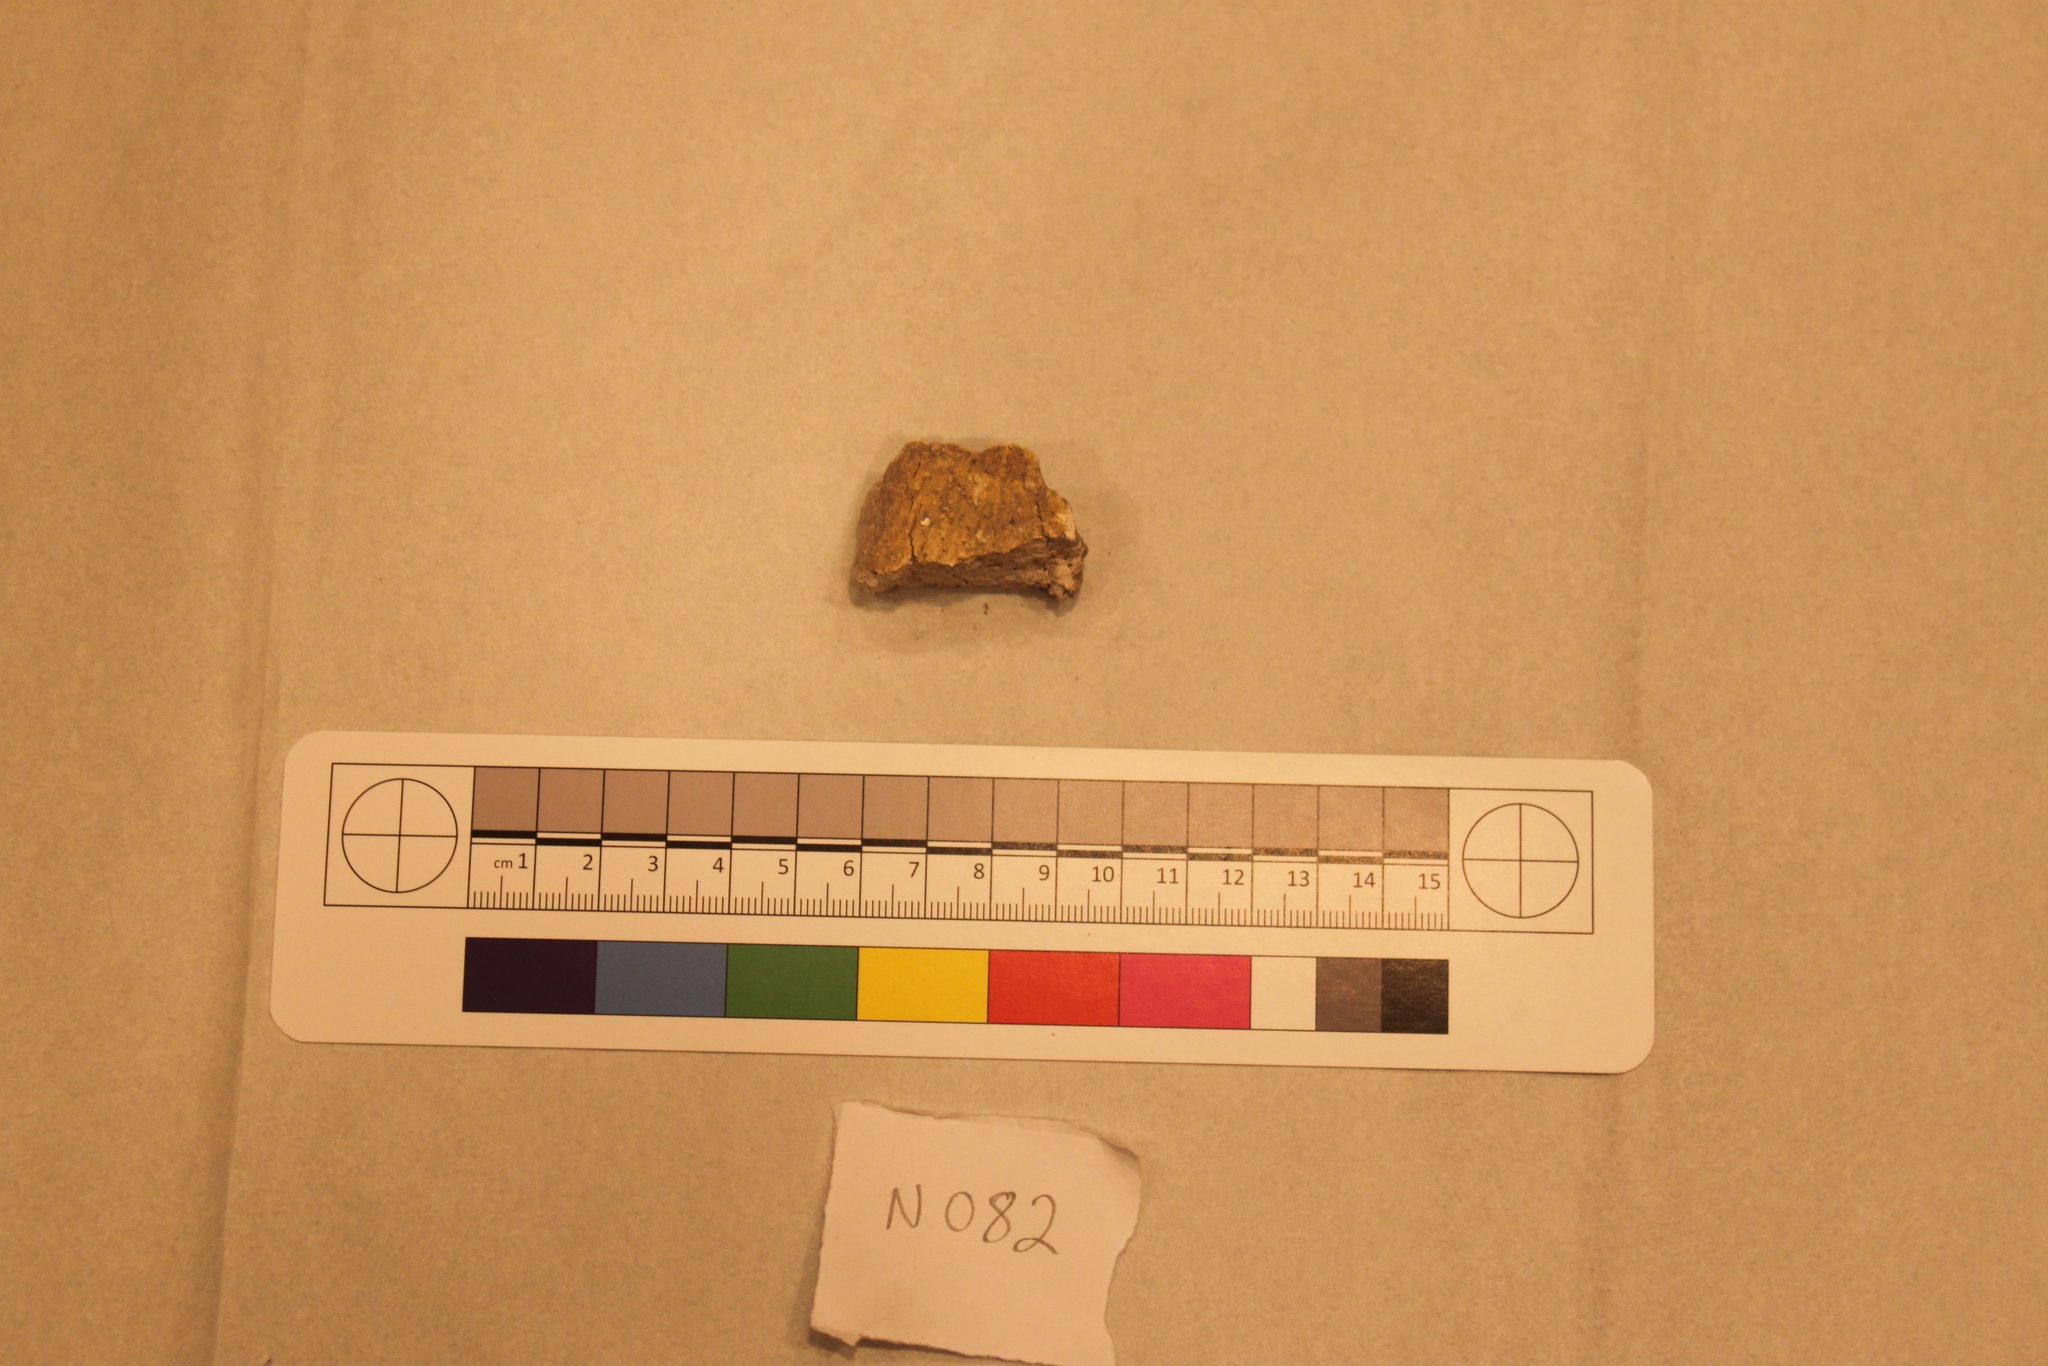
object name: fragment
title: Stucco Fragment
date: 701-1200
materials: plaster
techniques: painting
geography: iran